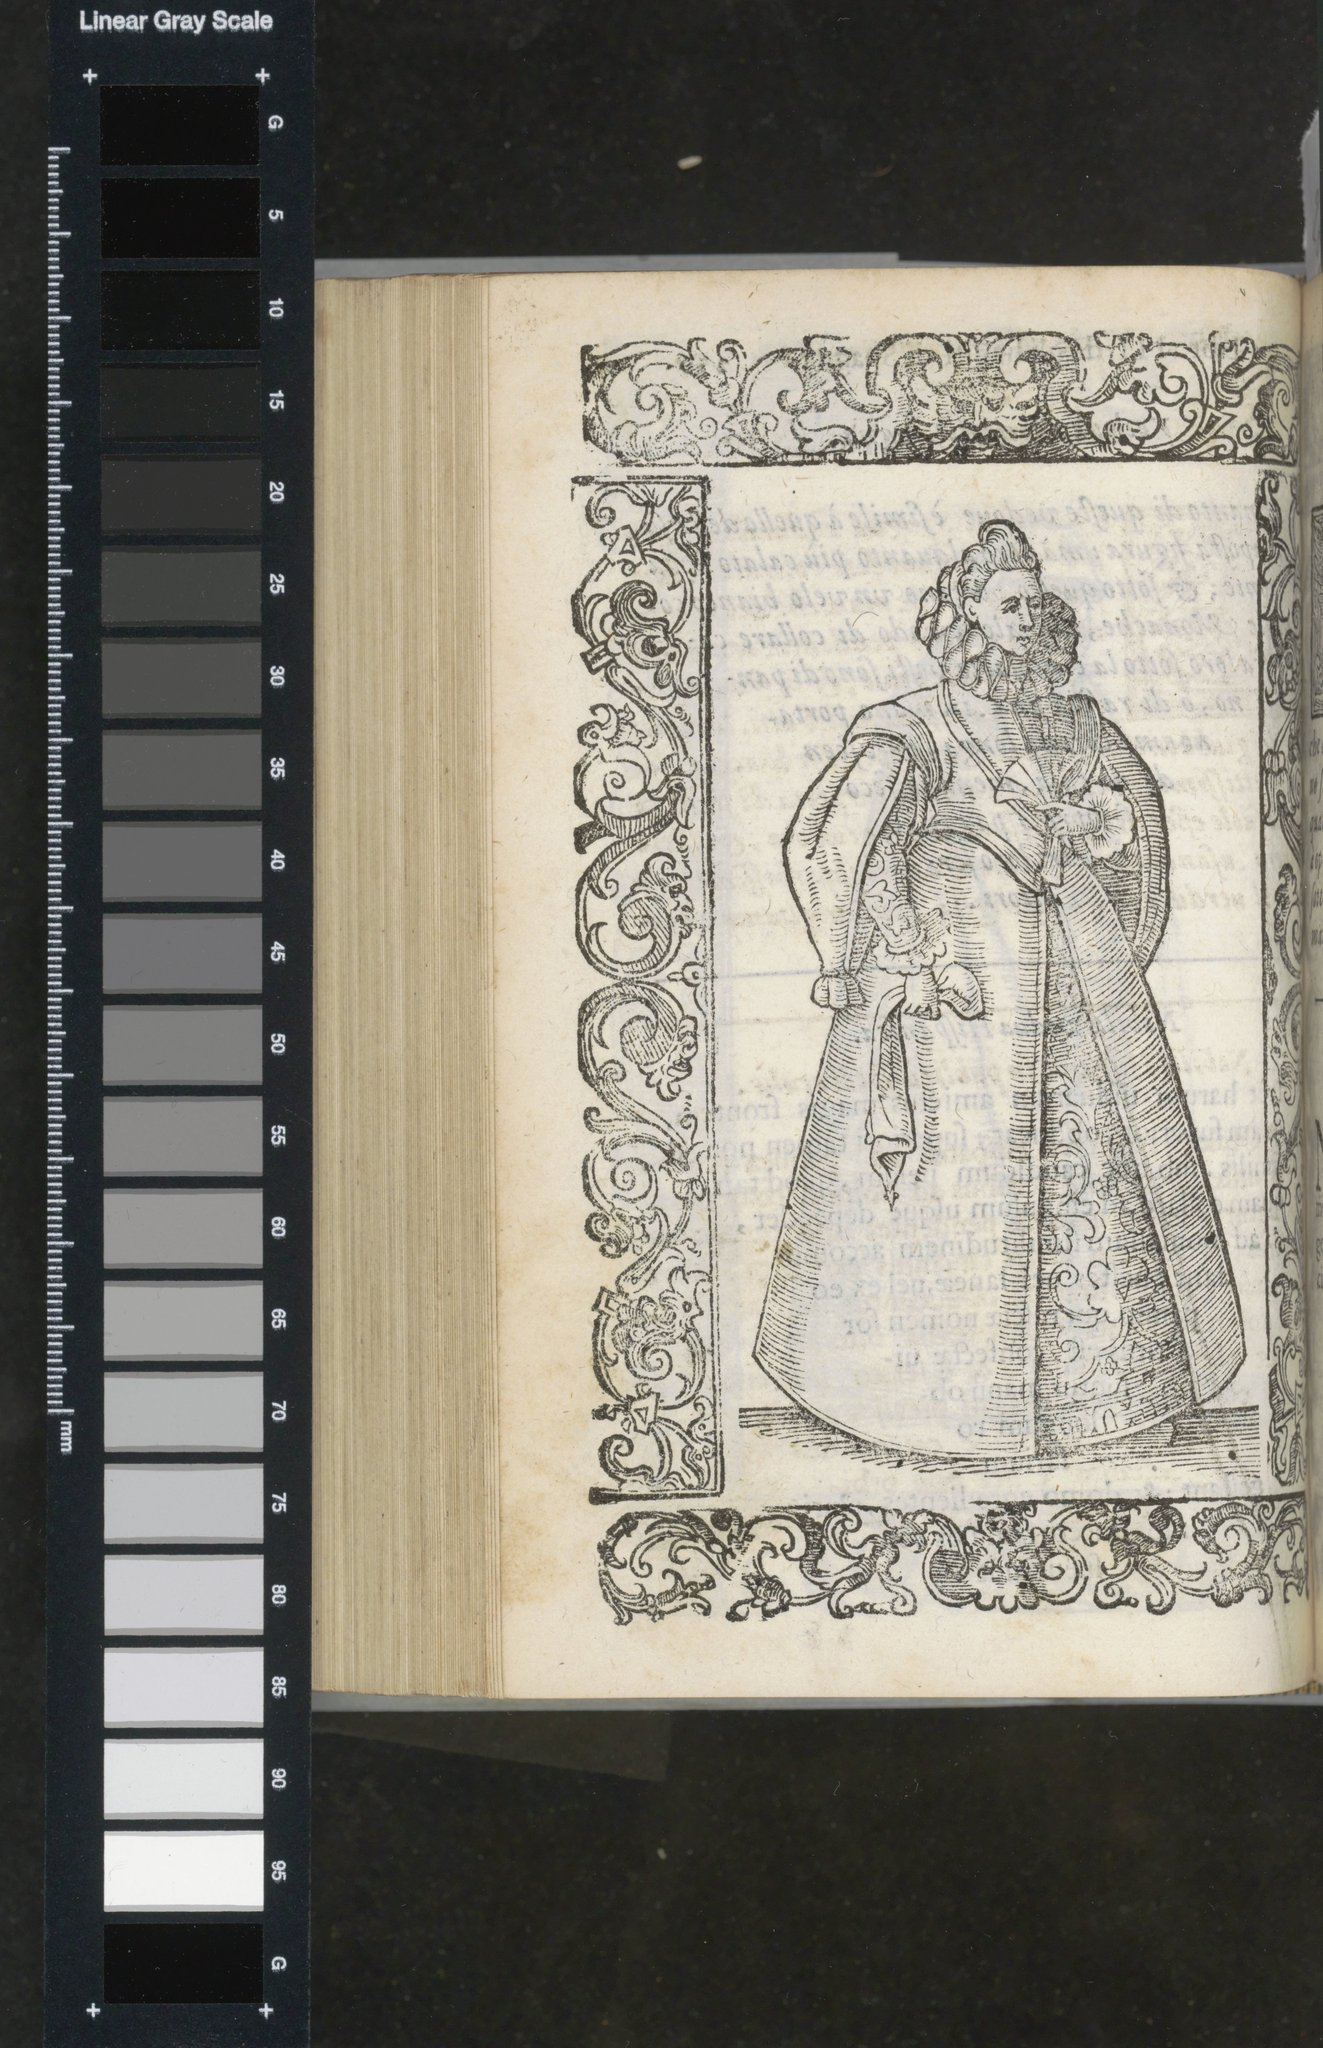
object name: costume print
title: Spagnuola nobile alle feste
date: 1598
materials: paper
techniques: woodcut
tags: fashion plates